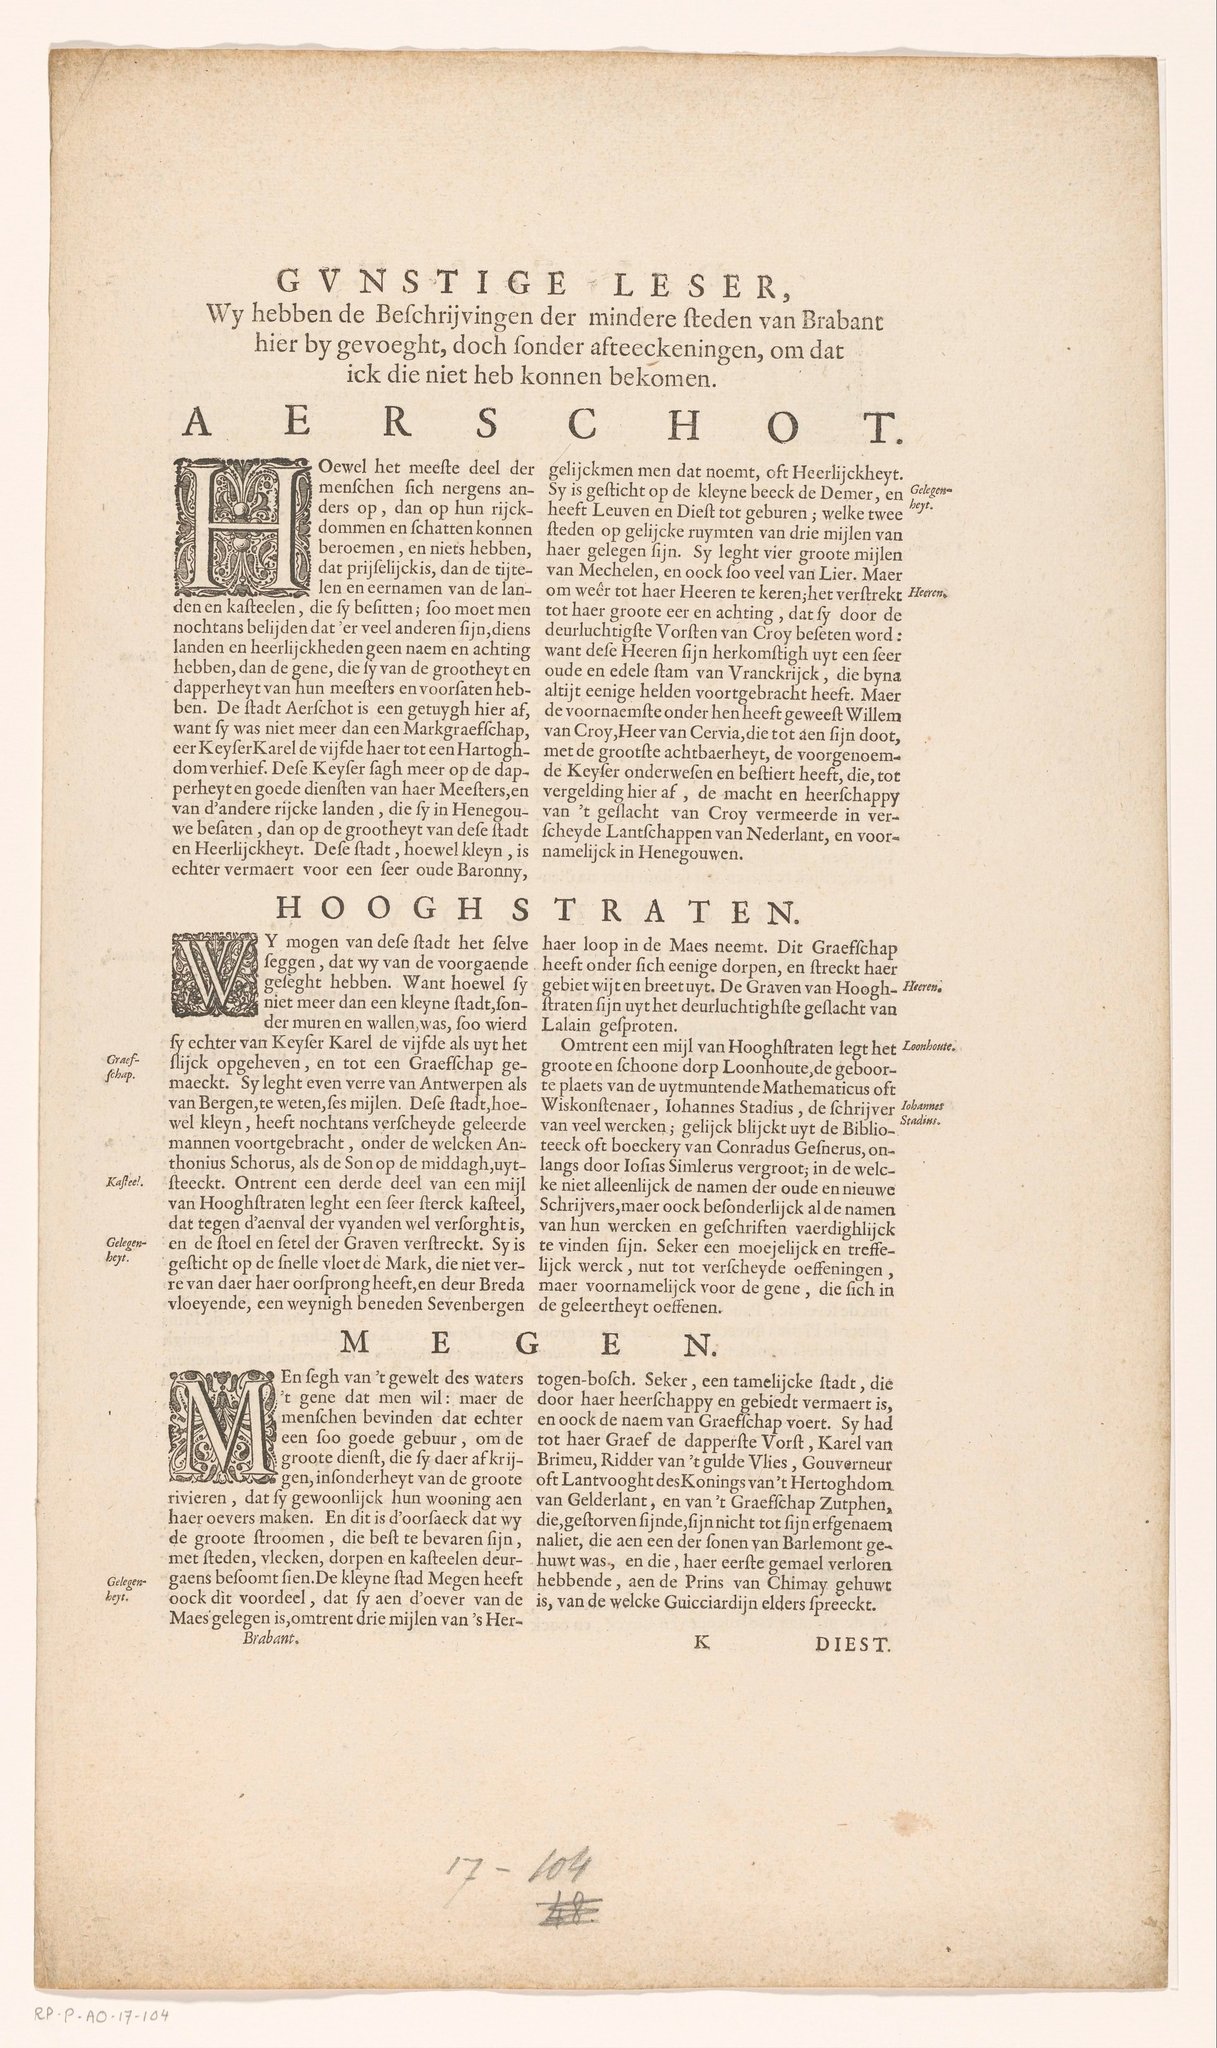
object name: text sheet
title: Beschrijving van Aarschot, Hoogstraten en Megen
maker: johannes willemszoon blaeu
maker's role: printer, publisher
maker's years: 1596-1673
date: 1652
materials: paper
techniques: letterpress printing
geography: amsterdam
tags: megen, hoogstraten, aarschot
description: Tekst gebruikt in: Blaeu, Johannes Willemszoon. Toonneel der steden van de Vereenighde Nederlanden. 2 delen. Amsterdam: Johannes Willemszoon Blaeu, 1652, dl. 2.